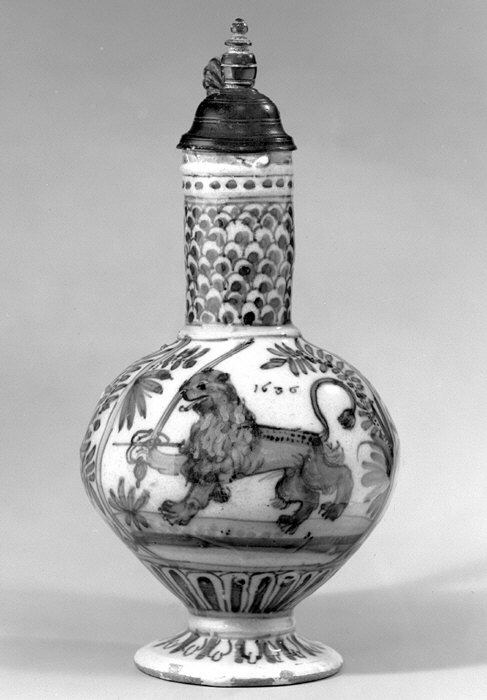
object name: tankard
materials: earthenware, pewter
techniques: glazing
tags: swords,lions